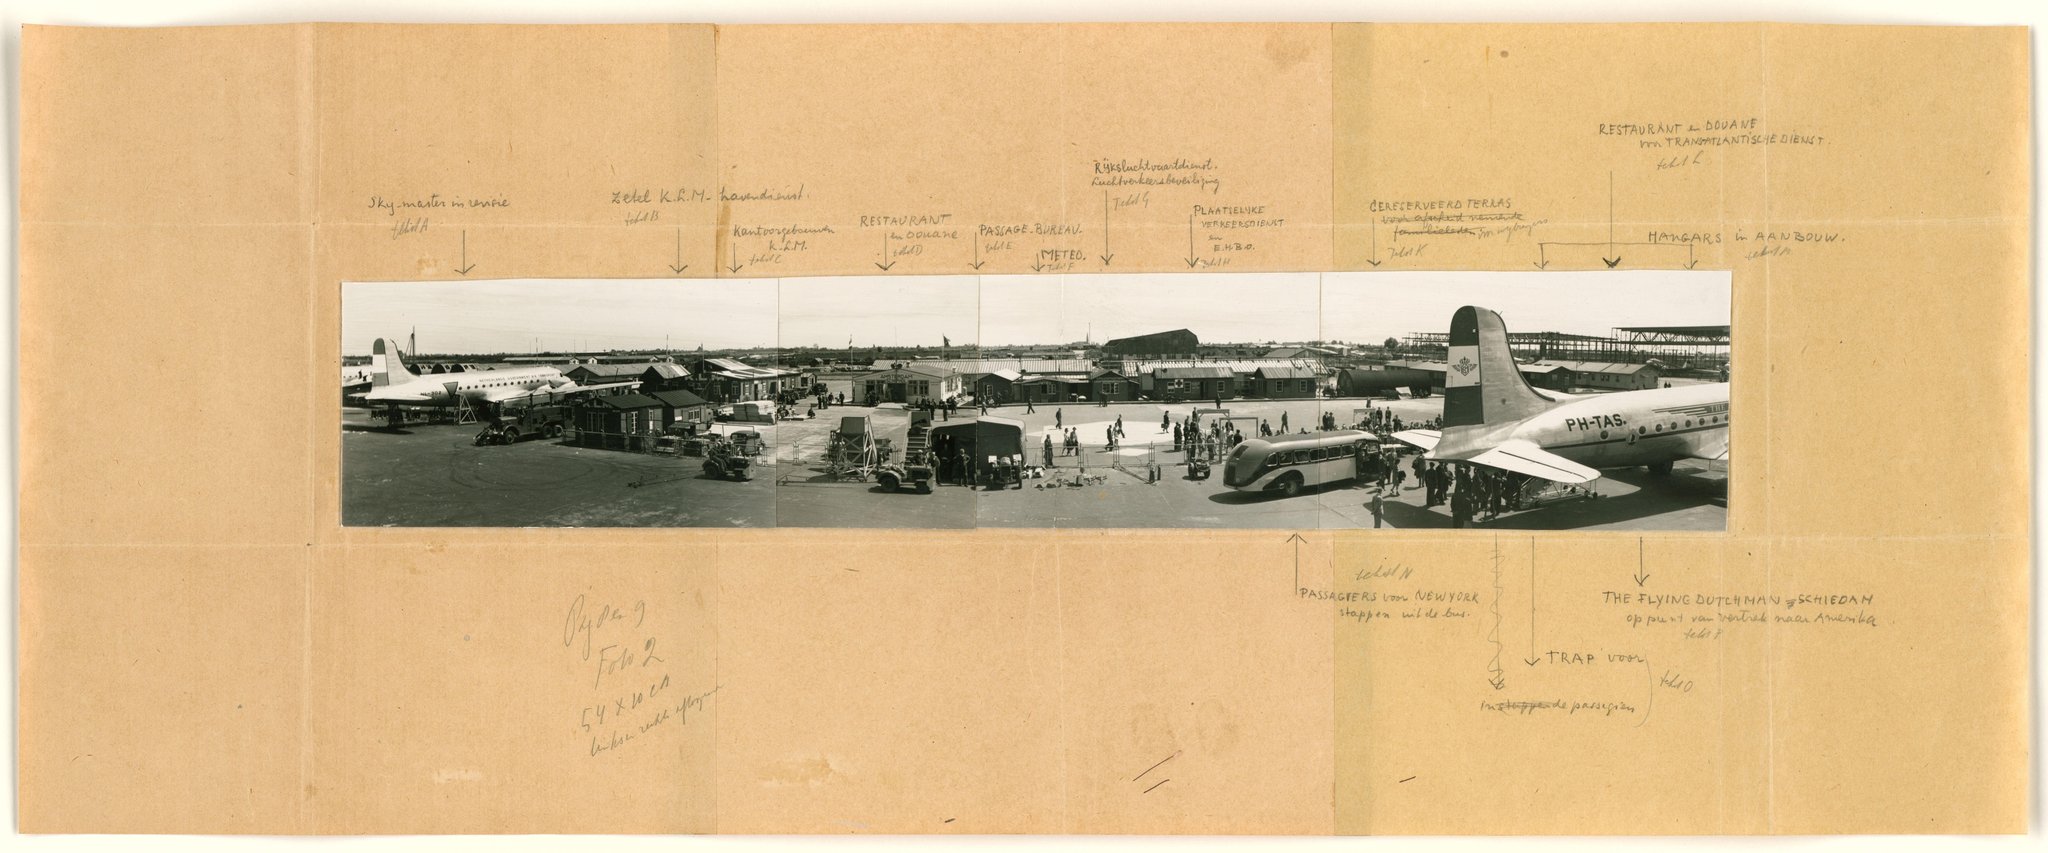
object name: documentary photograph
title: Schiphol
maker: Anonymous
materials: paper, photographic support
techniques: photography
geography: amsterdam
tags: amsterdam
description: Panoramafoto van de luchthaven Schiphol. Op de foto zijn diverse noodgebouwen te zien, hangars in aanbouw en vliegtuigen voor binnenlandse vluchten, internationale en intercontinentale, zoals naar New York. Onder en boven de foto staan met potlood diverse details beschreven over de vliegtuigen, de gebouwen etc. bedoeld als bijschrift in een publicatie. Foto bestaat uit drie delen, geplakt op beige papier. Over de foto ligt vloeipapier met opschriften.